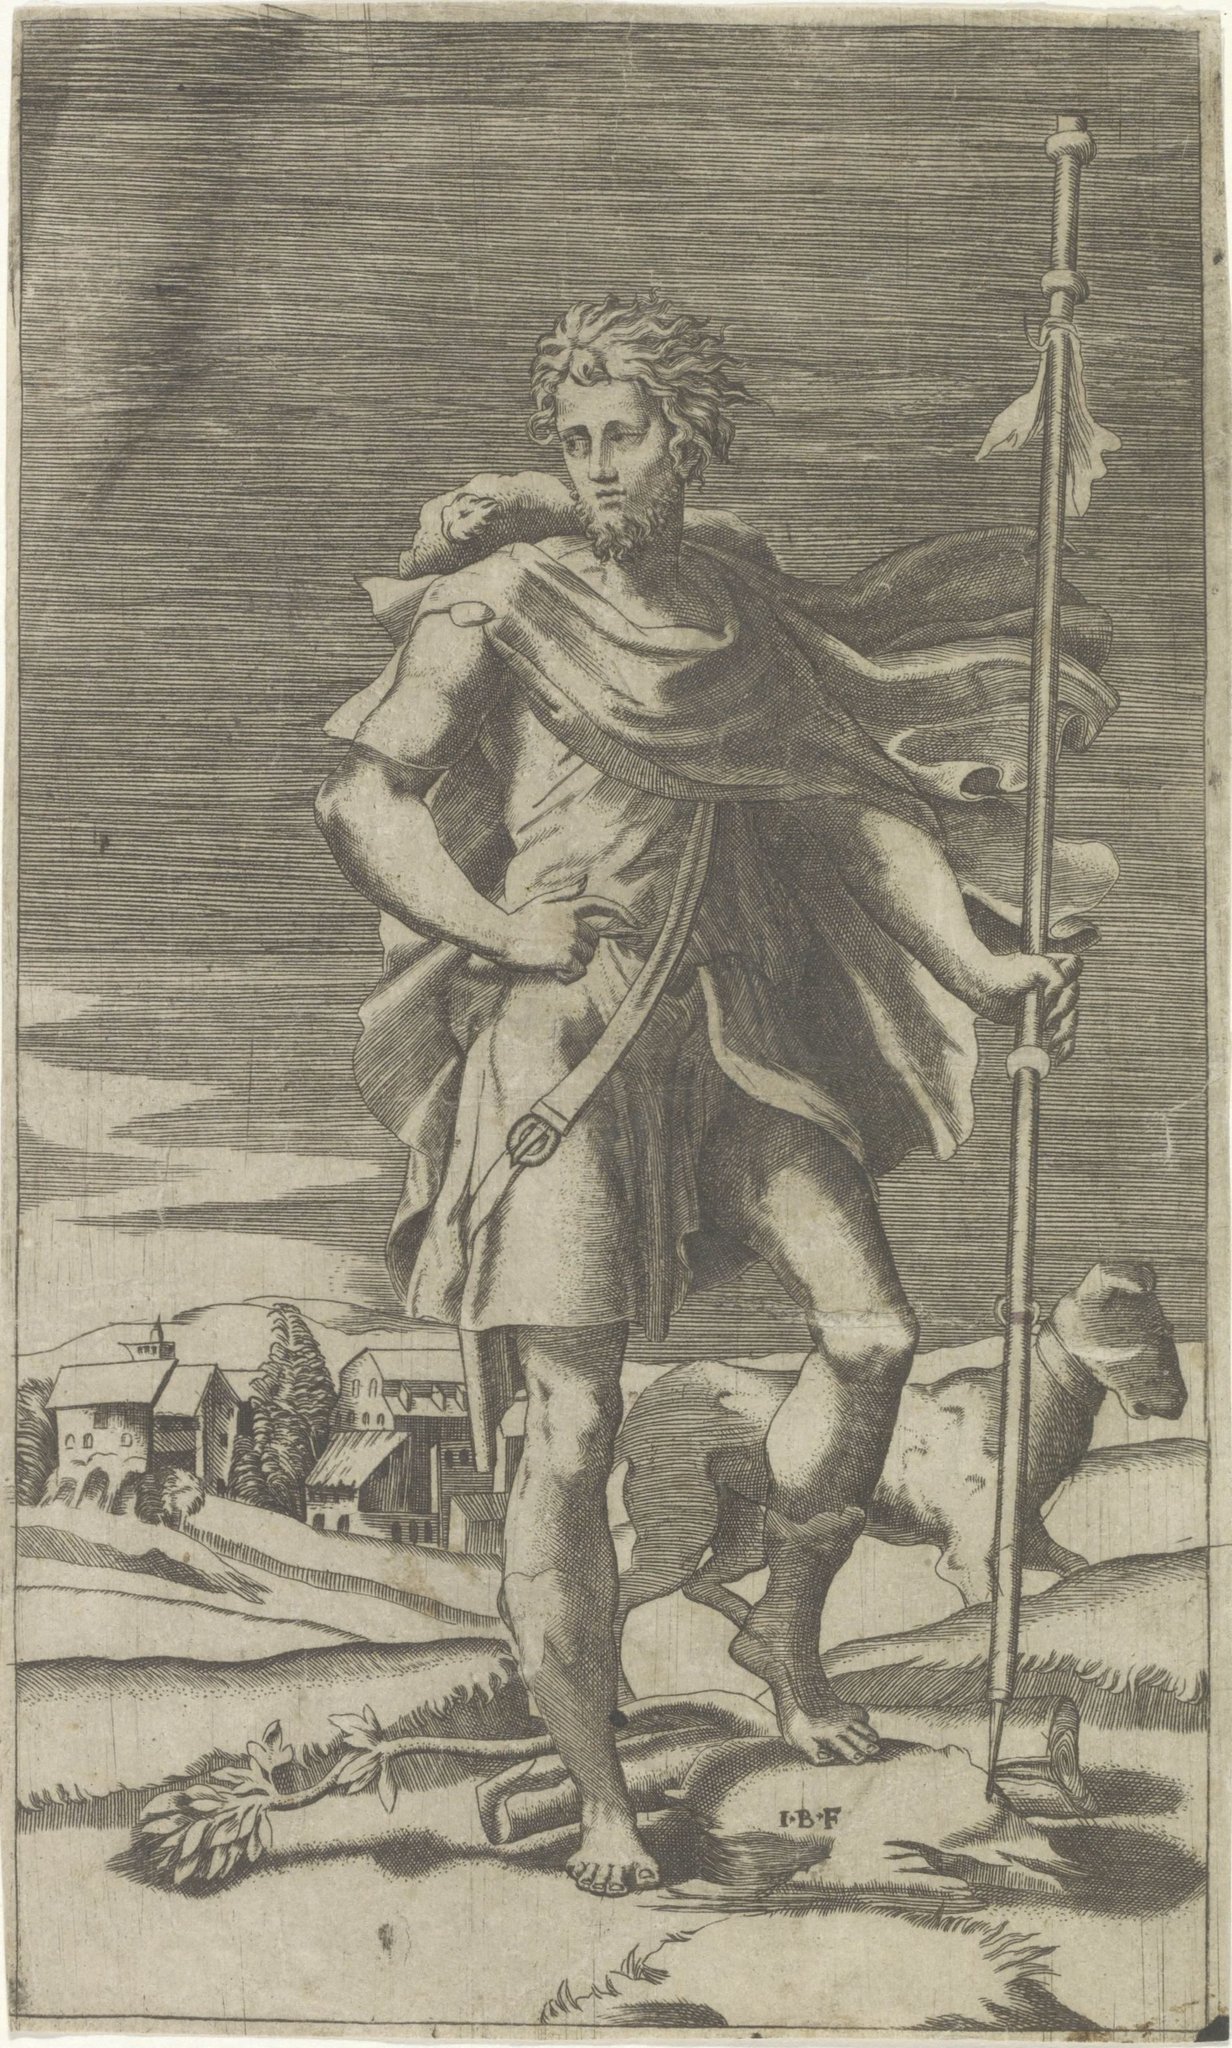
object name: print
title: Heilige Rochus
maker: giulio bonasone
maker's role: painter, print maker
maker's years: 1510-1576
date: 1501-1580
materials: paper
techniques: engraving, etching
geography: italy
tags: the confessor and pilgrim roch(us) (rocco, rock) of montpellier; possible attributes: angel (with ointment box or spoon), dog (sometimes with loaf), (pointing at) plague-spot on thigh, pilgrim's shell, staff, hat and wallet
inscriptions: collector's mark: Lugt 2228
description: De heilige Rochus staand in een landschap. Achter hem een hond.